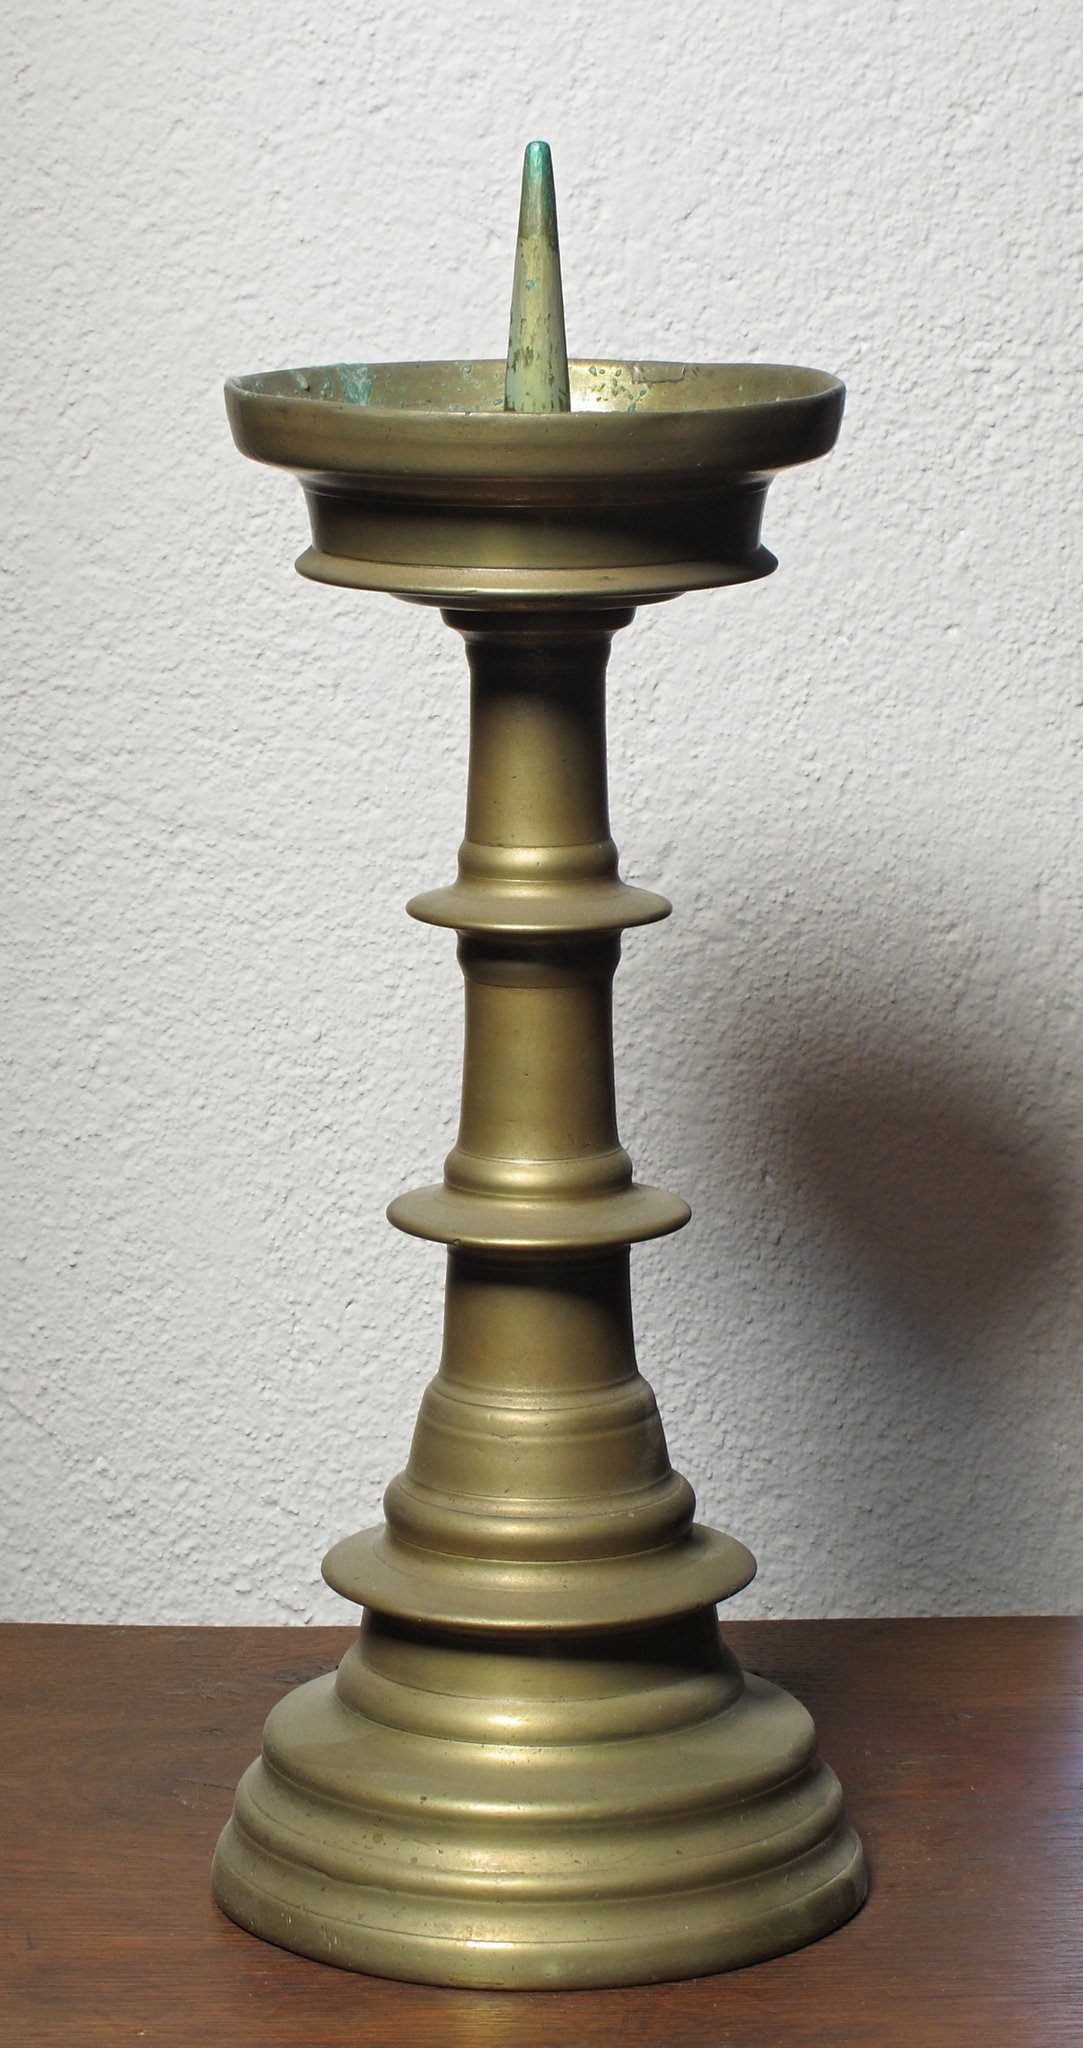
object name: candlestick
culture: german or south netherlandish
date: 1467-1500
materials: copper alloy